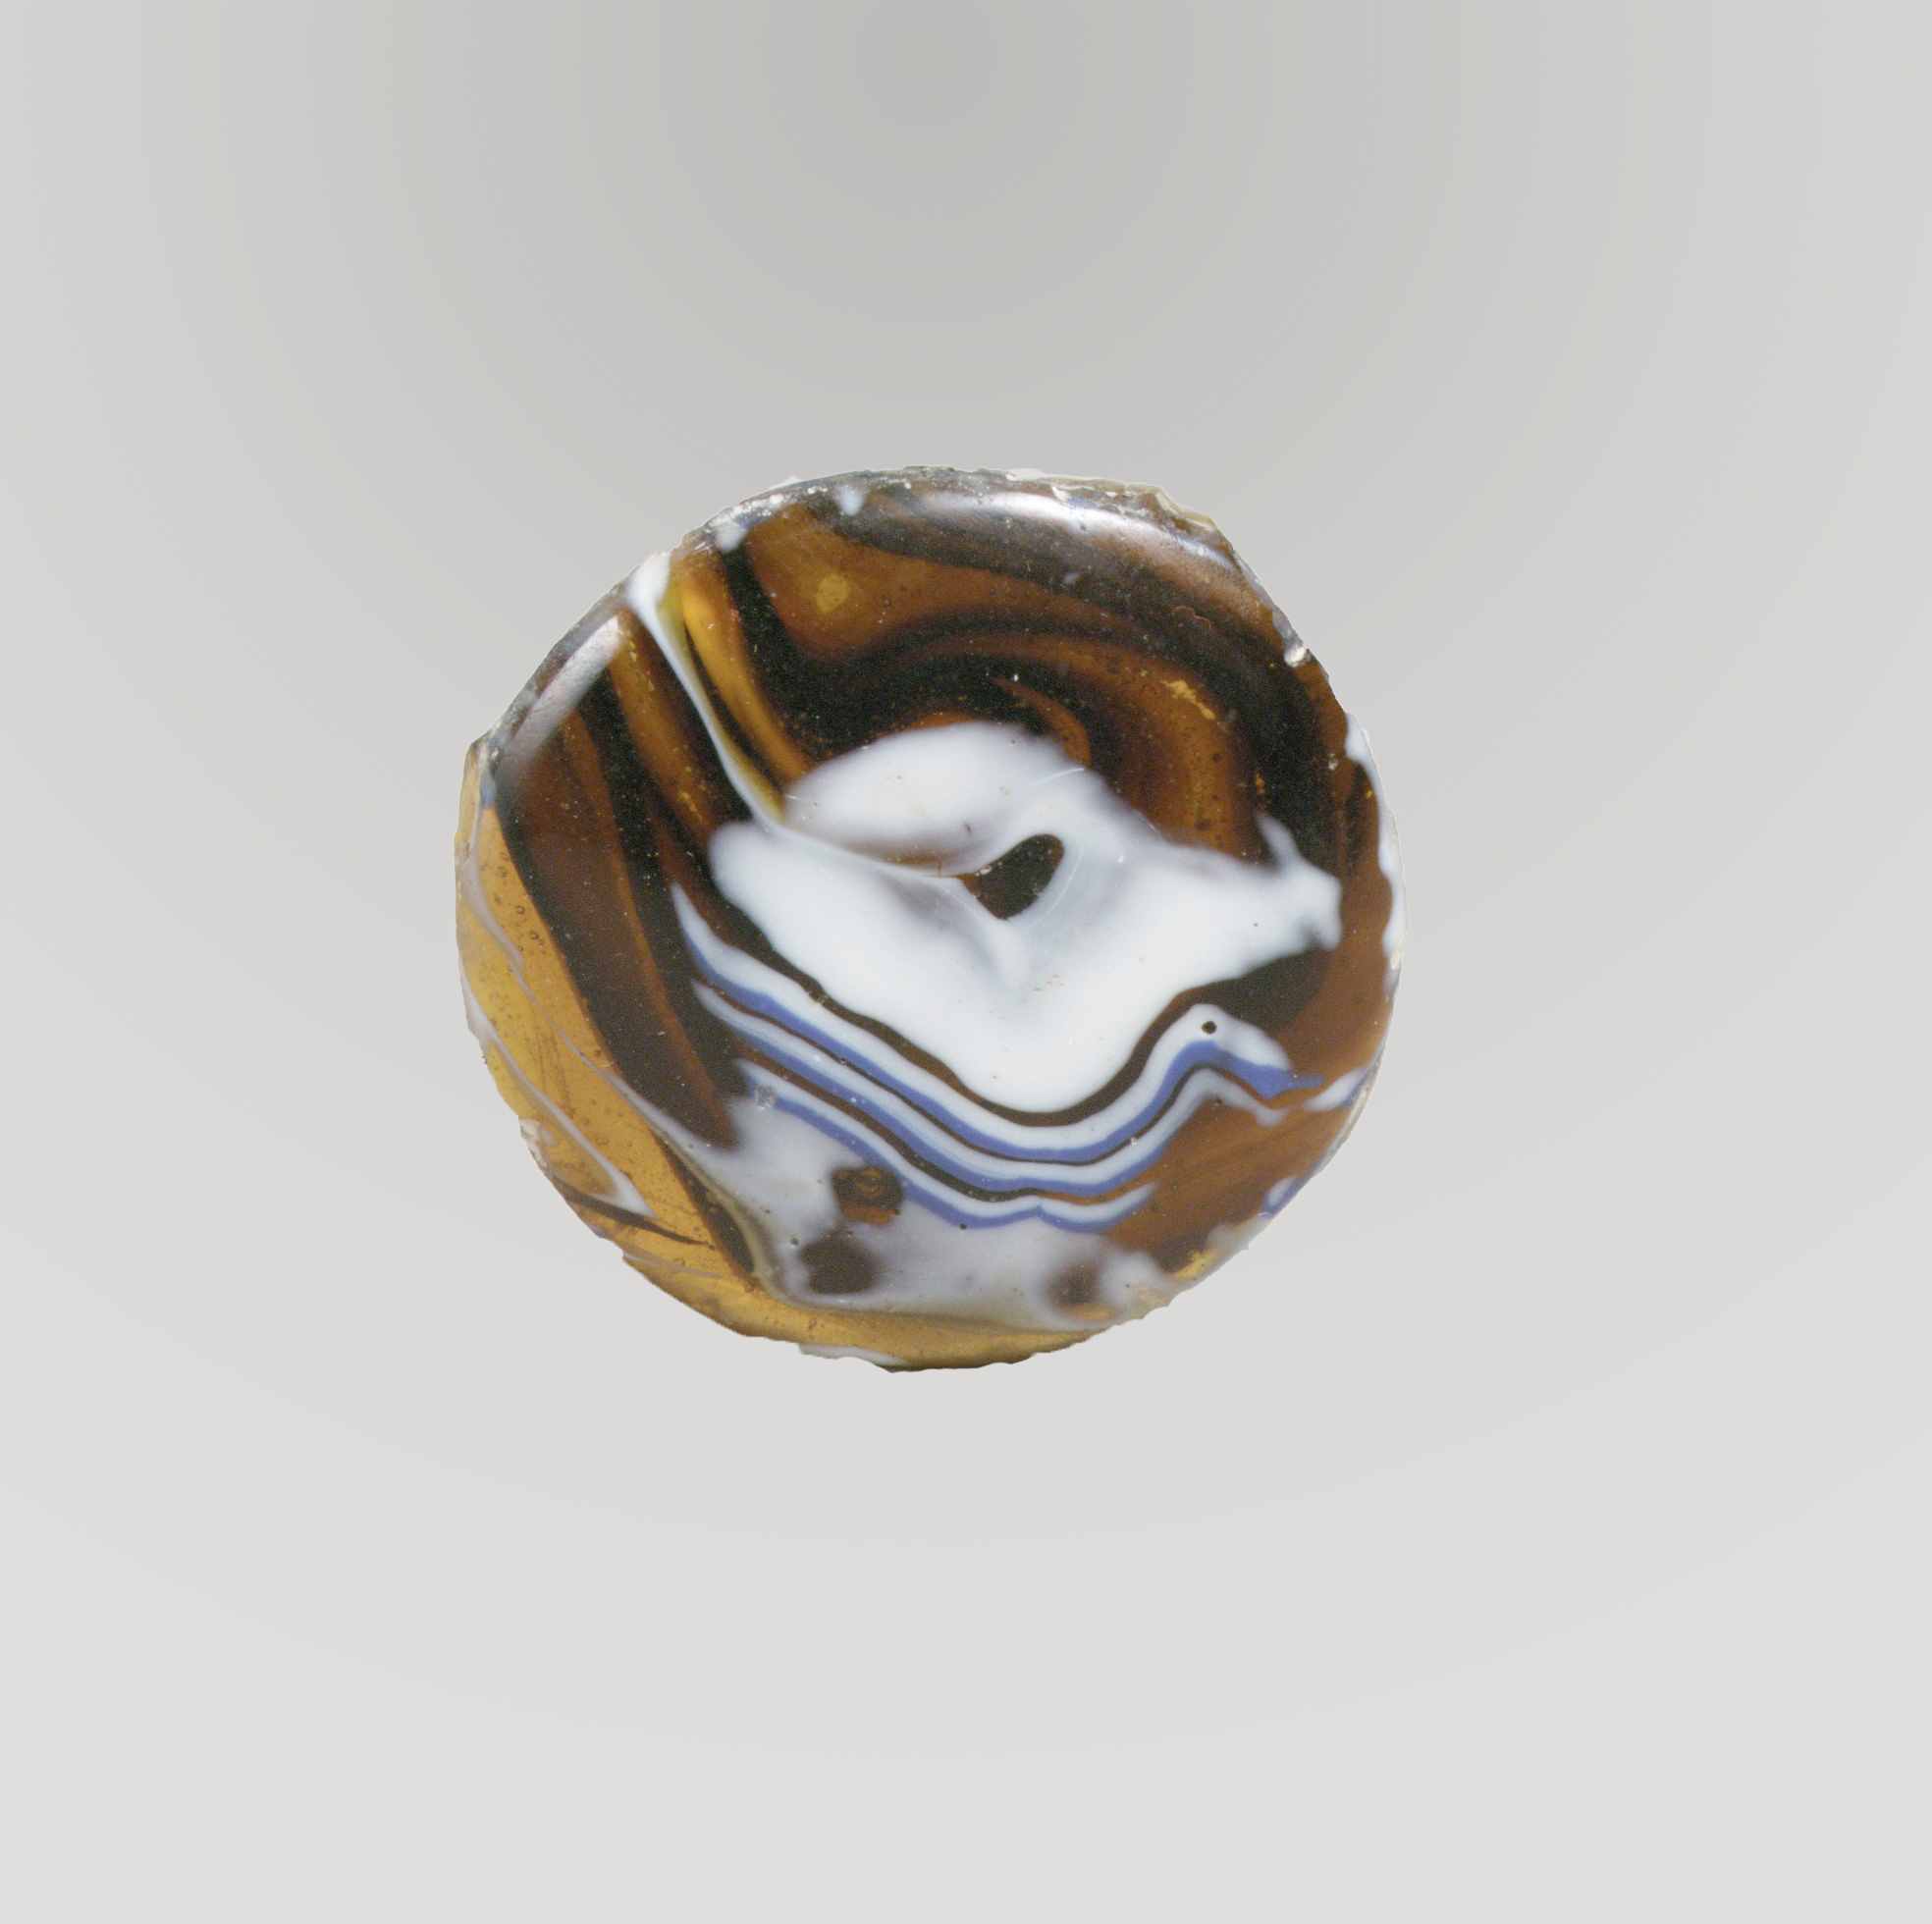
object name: fragment, mosaic bowl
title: Glass mosaic bowl fragment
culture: roman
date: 34 BCE-33 CE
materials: glass